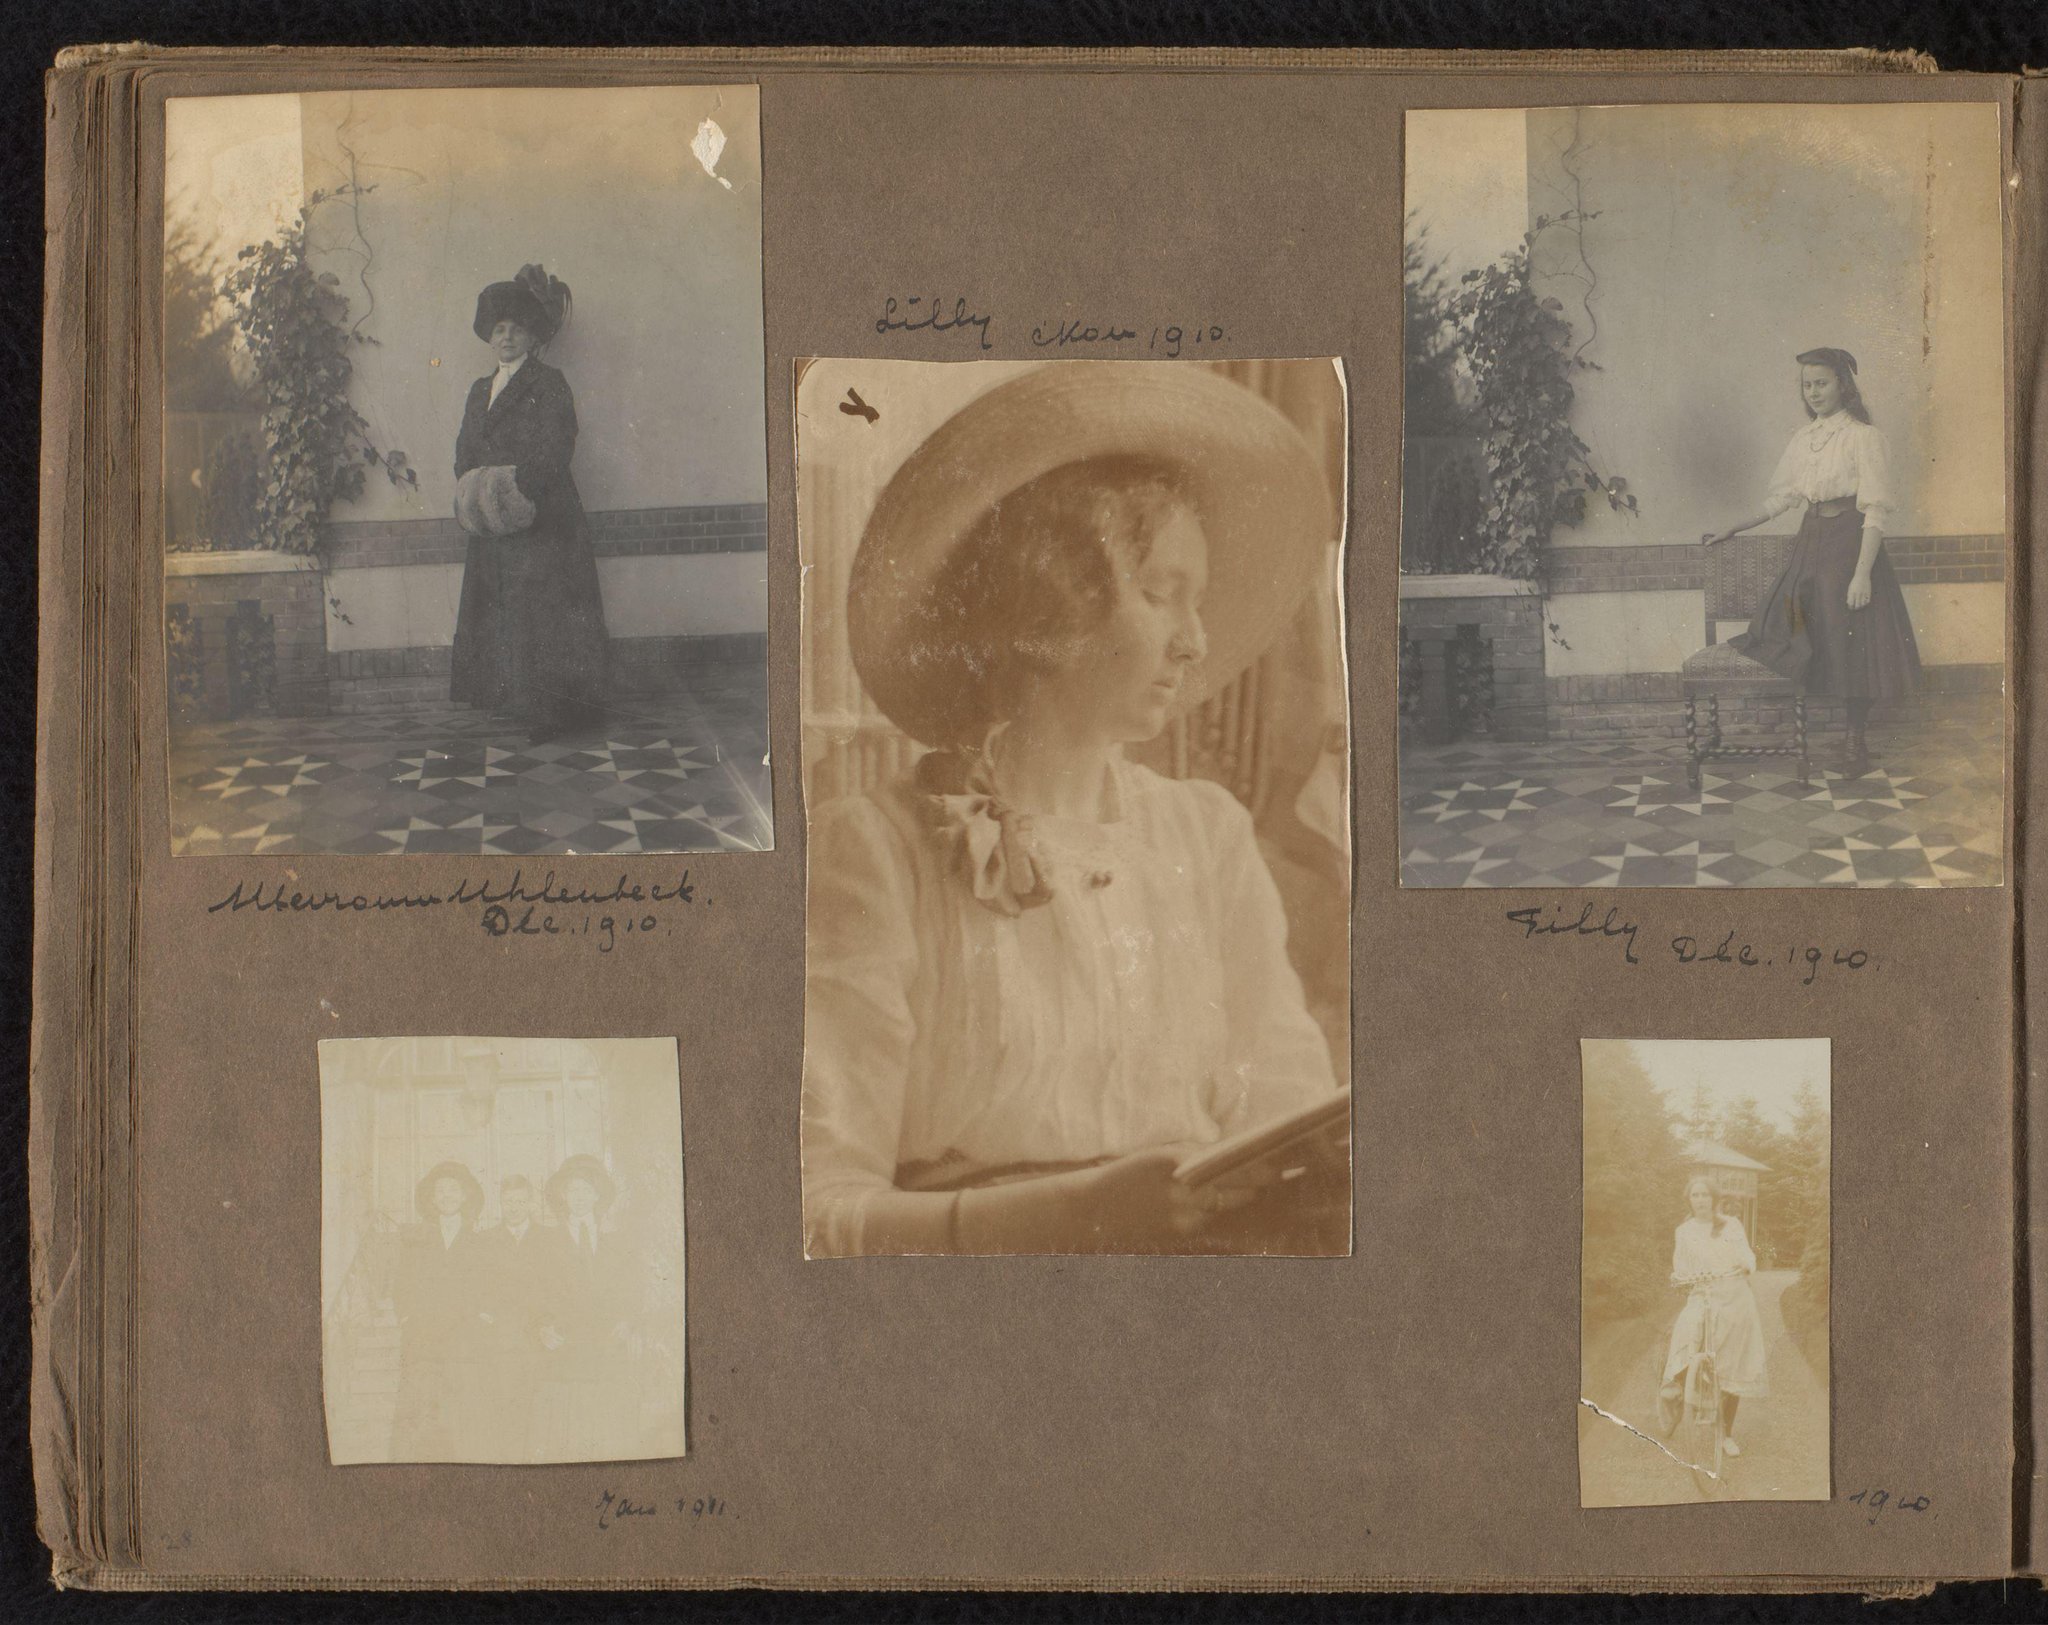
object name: photograph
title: Vijf foto's van mensen uit de omgeving van Loentje Onnen, onder andere Johanna Uhlenbeck, Lilly en Tilly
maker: carolina frederika onnen (lien/loen)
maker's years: 1896-1983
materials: paper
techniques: gelatin silver print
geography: netherlands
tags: batavia, the hague, historical persons - bb - woman, bicycle, friends, netherlands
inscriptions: inscription: ‘Lilly Nov 1910’, inscription: ‘Tilly Déc. 1910’, inscription: ‘Jan. 1911’, inscription: ‘Mevrouw Uhlenbeck/ Déc. 1910’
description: Deze foto's maken deel uit van een album.